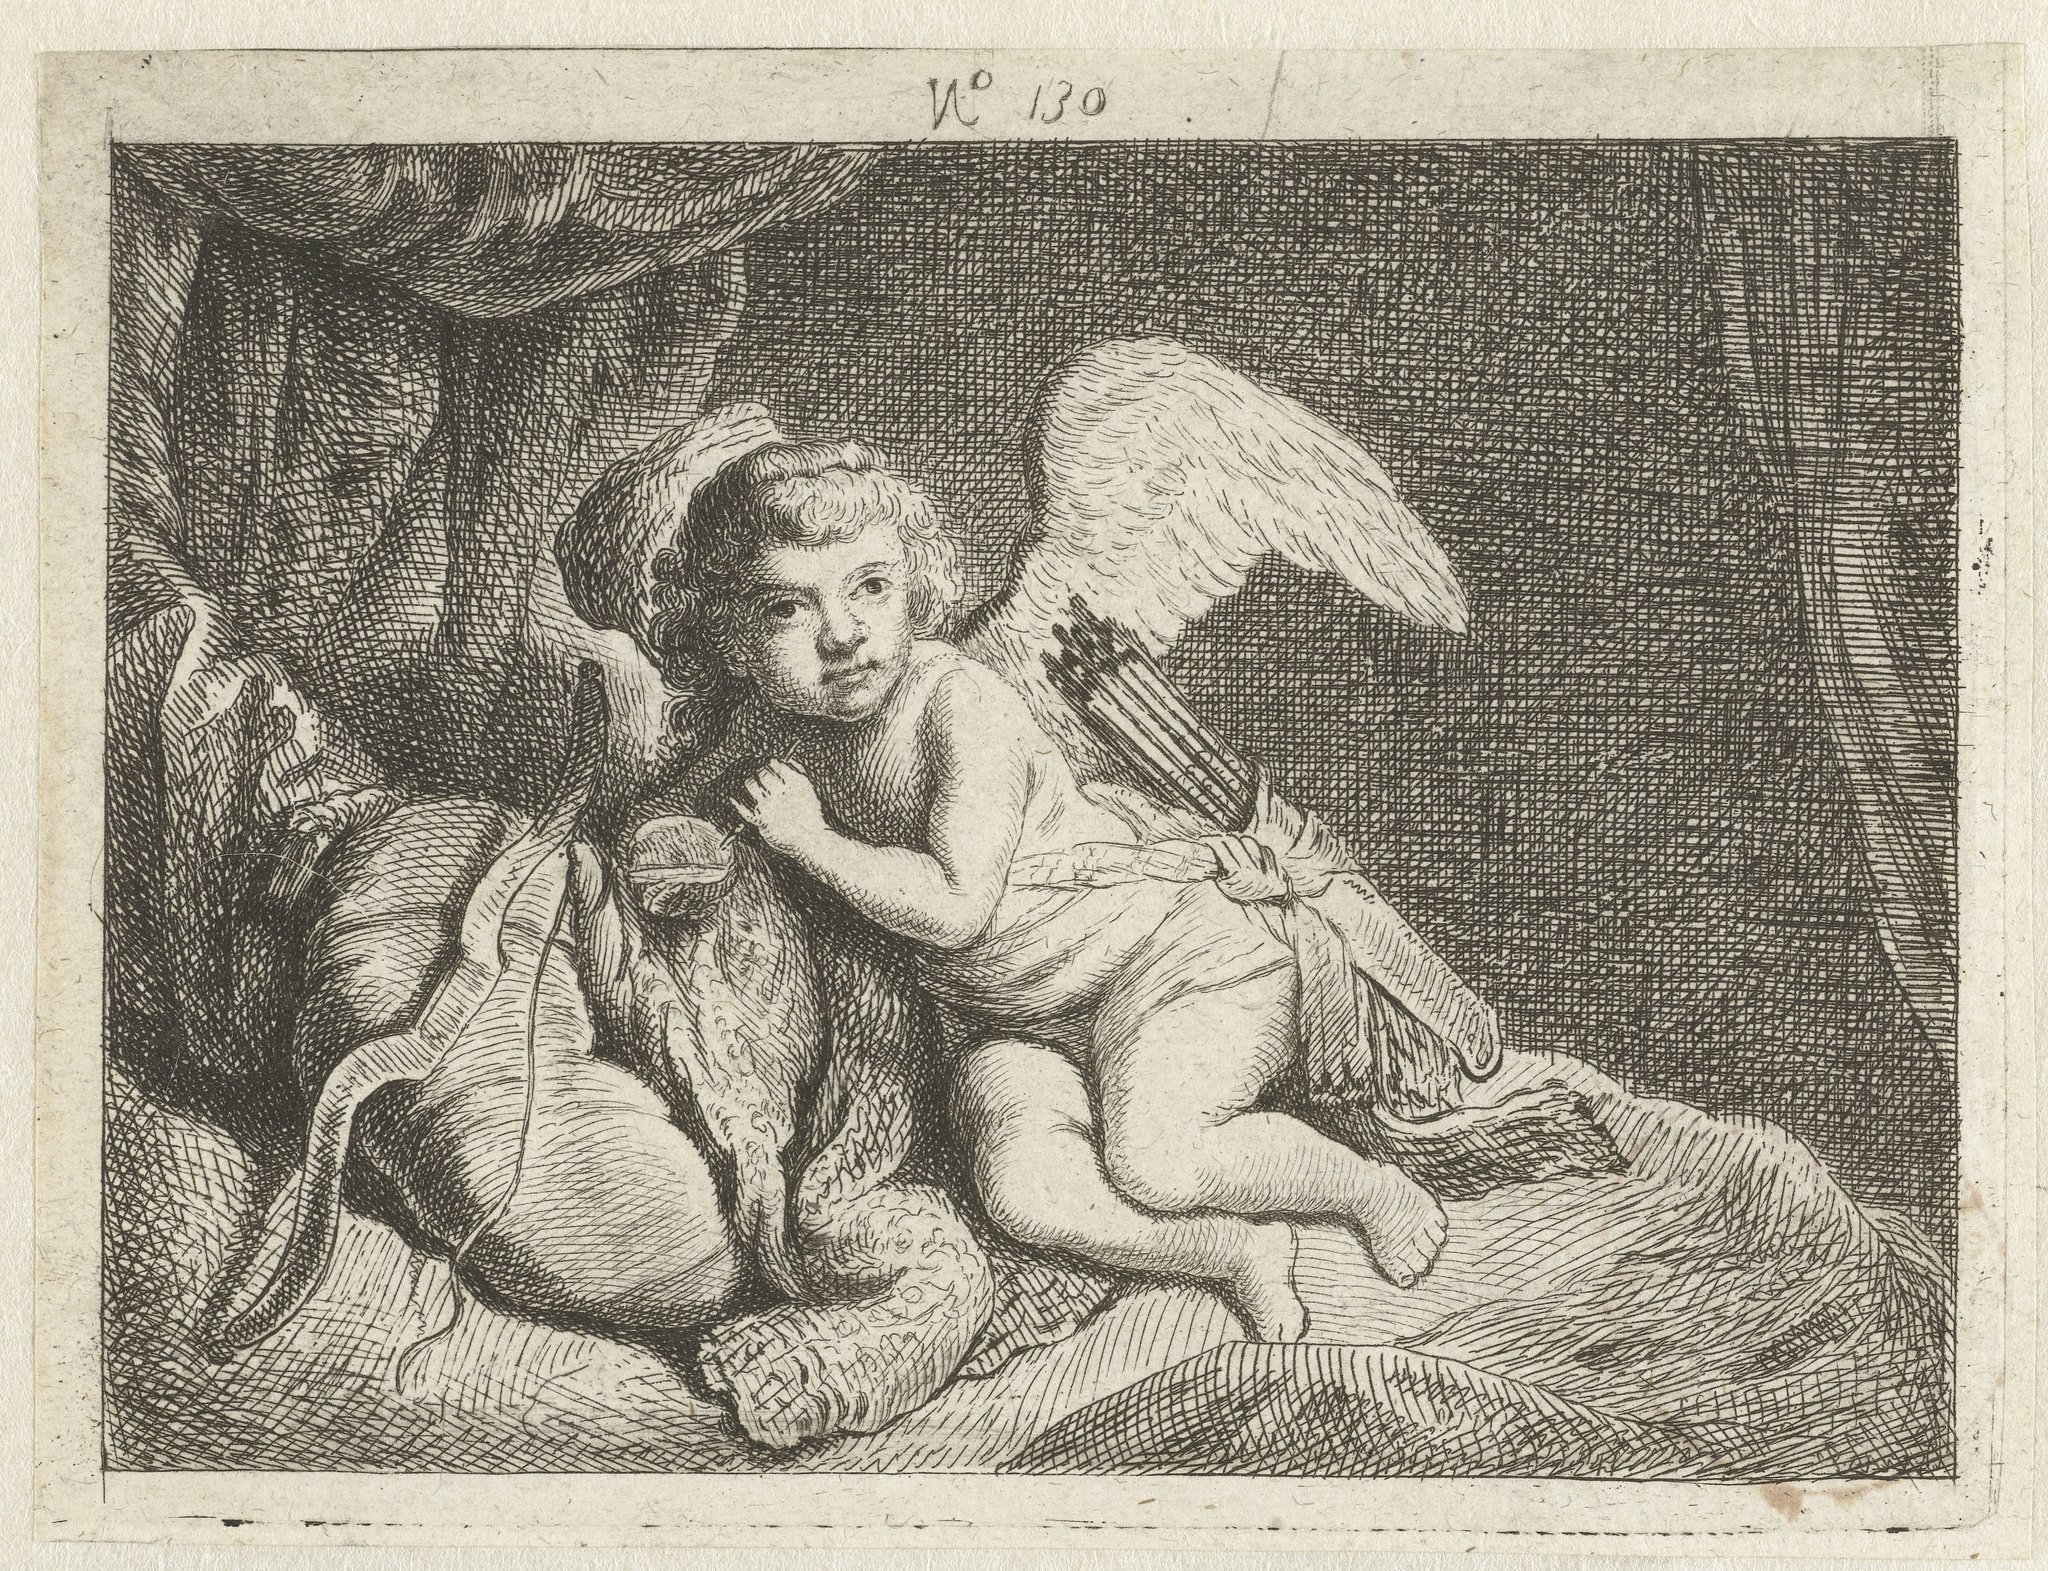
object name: print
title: Rustende Amor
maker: pierre françois basan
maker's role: print maker, publisher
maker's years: 1723-1797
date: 1733-1797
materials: paper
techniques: etching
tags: (story of) cupid, amor (eros)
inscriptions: collector's mark: Lugt 240